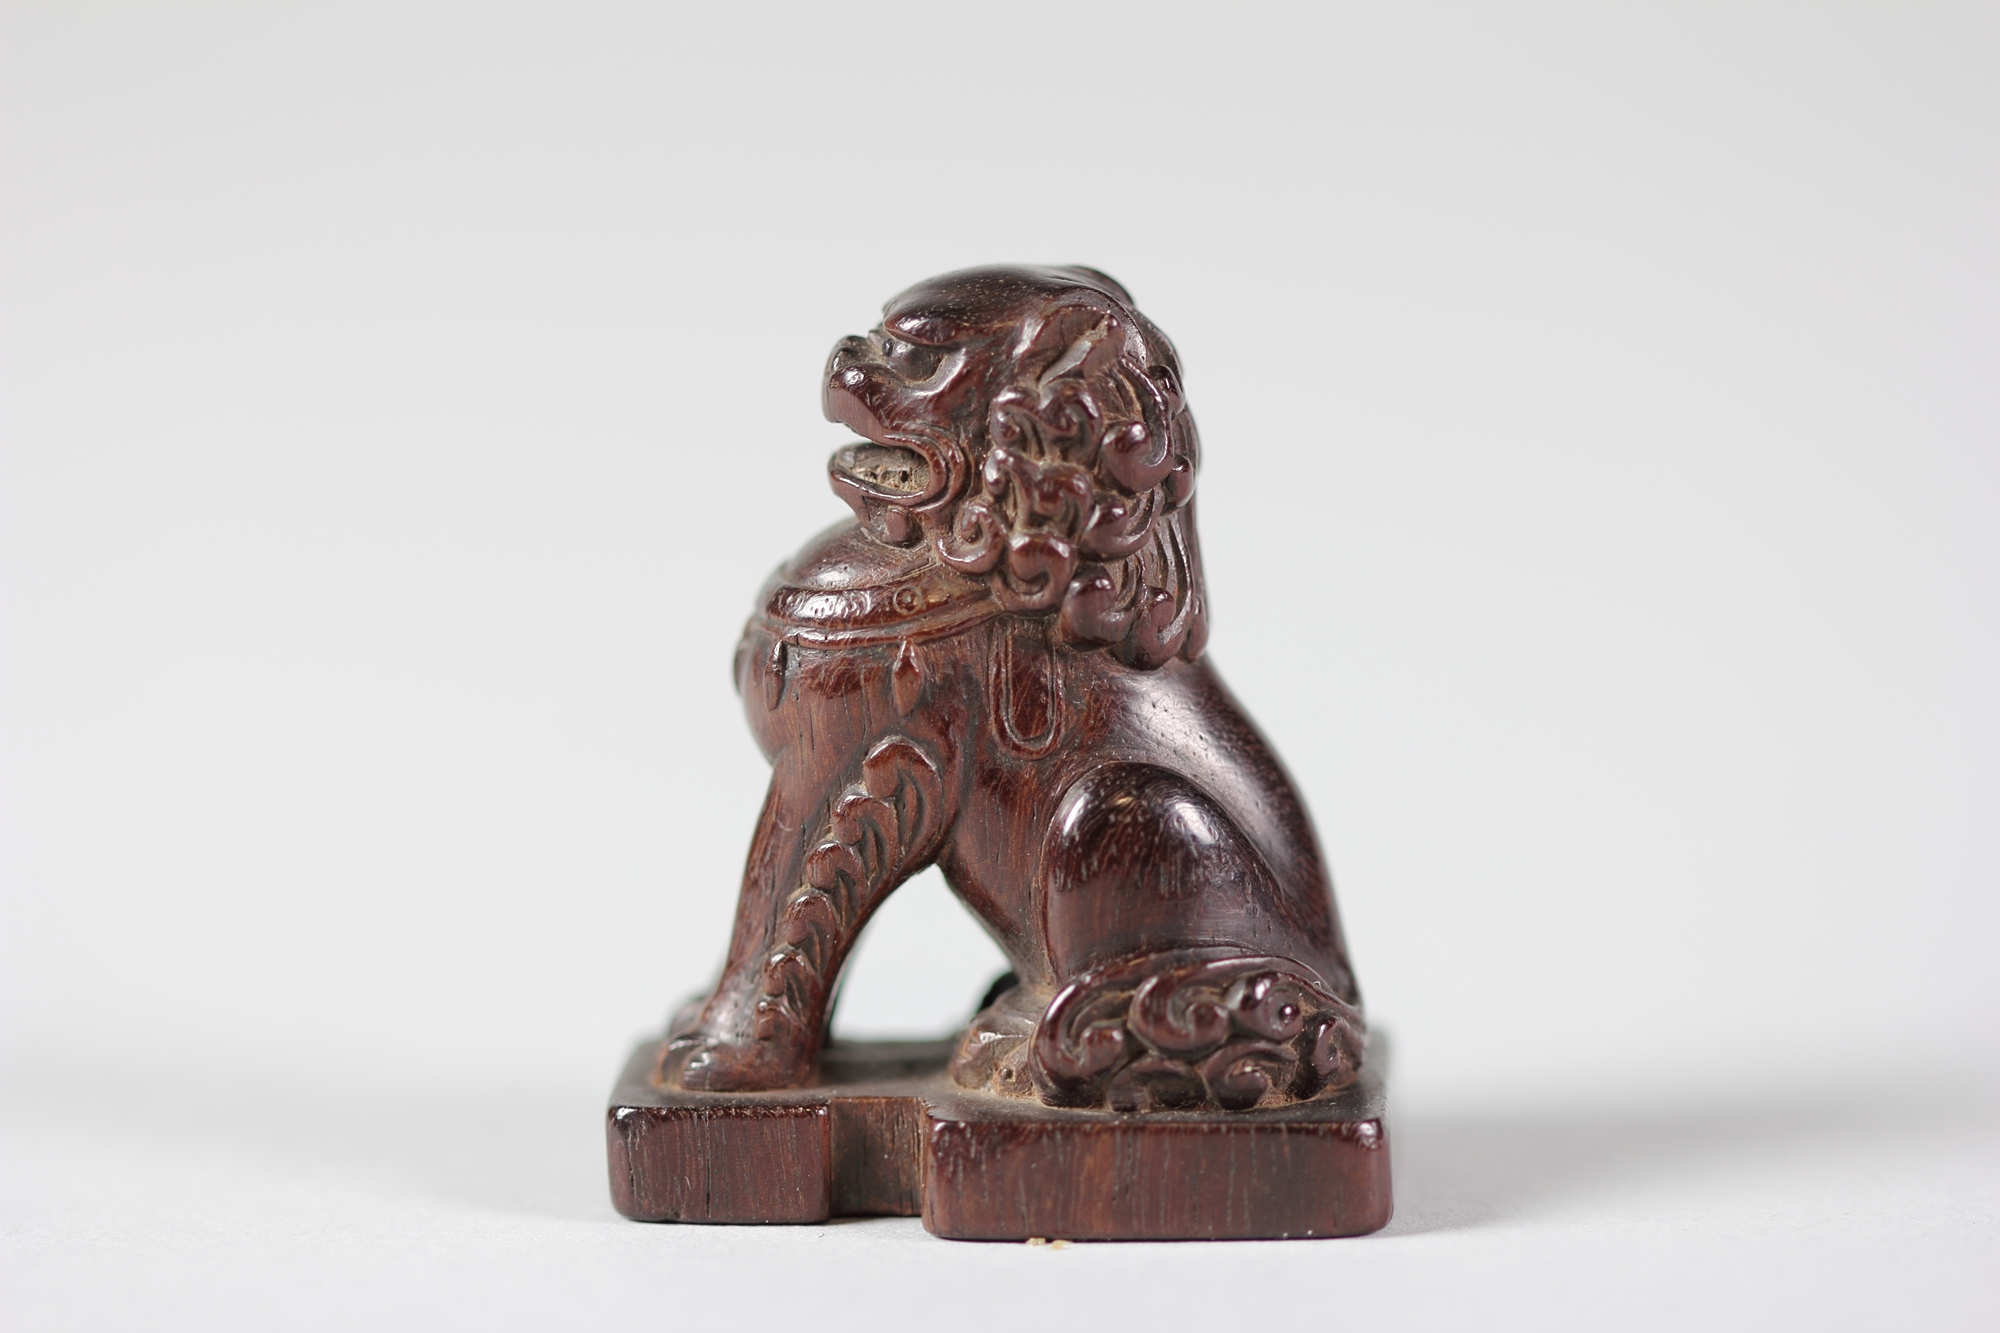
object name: netsuke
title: Netsuke of Seated Lion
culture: japanese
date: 1701-1800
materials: wood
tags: lions